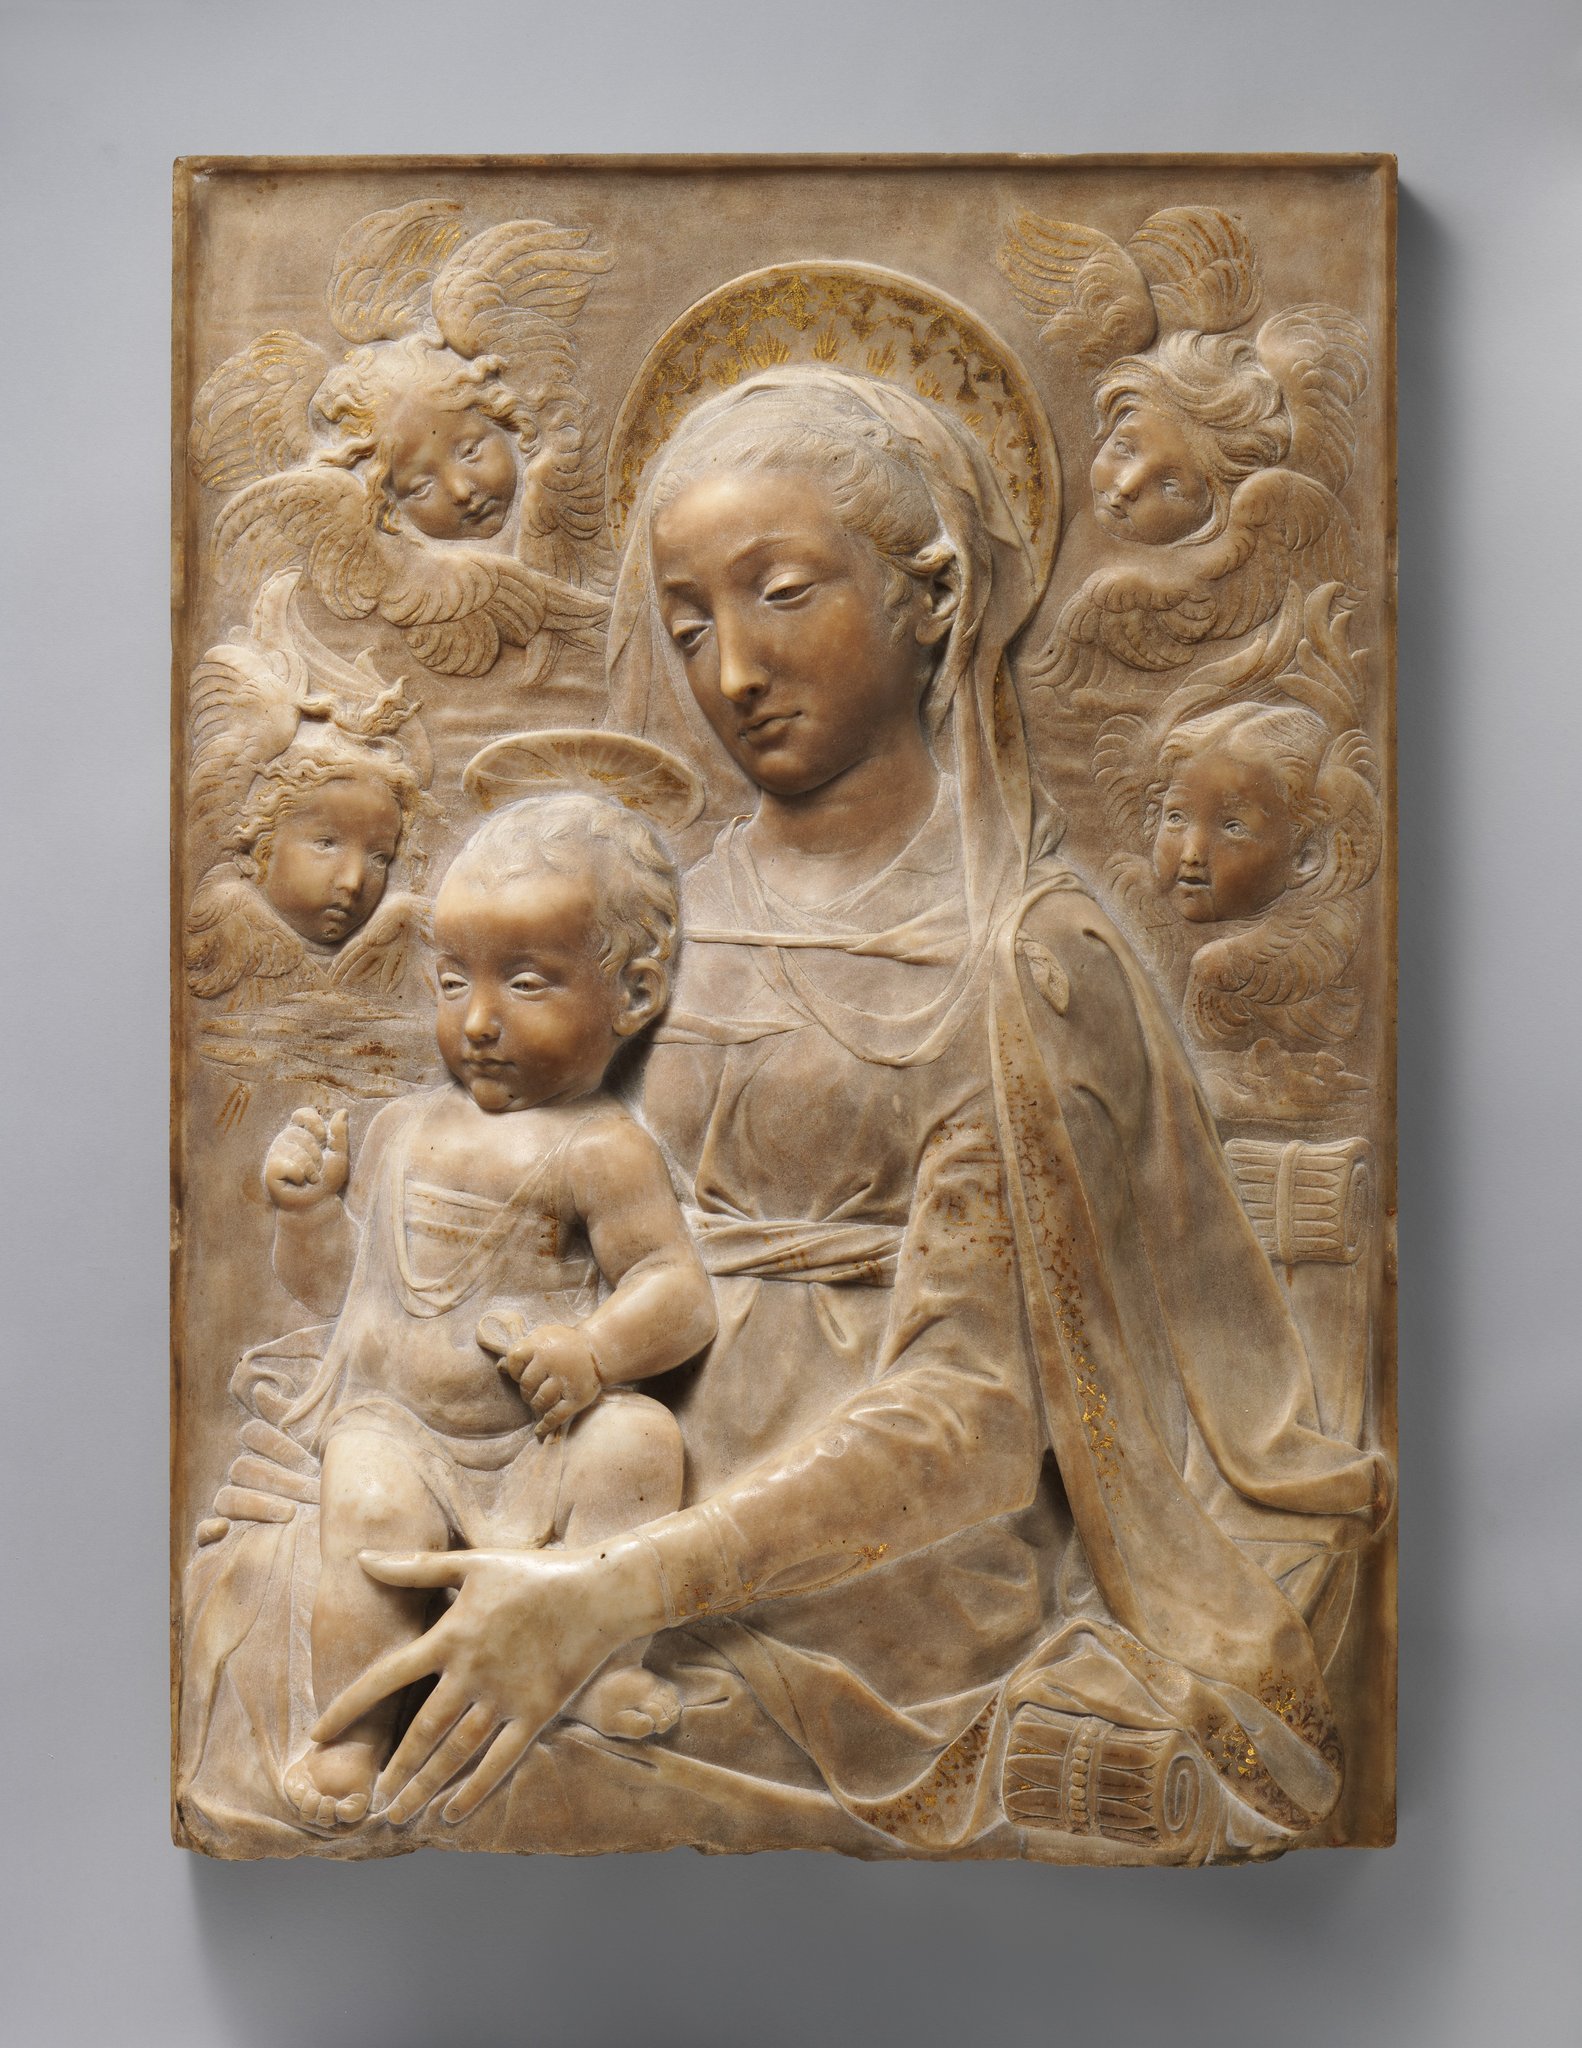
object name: relief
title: Madonna and Child with Angels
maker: antonio rossellino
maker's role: artist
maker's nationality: italian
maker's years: 1427-1479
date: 1455-1460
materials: gilt, marble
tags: infants,women,angels,madonna and child